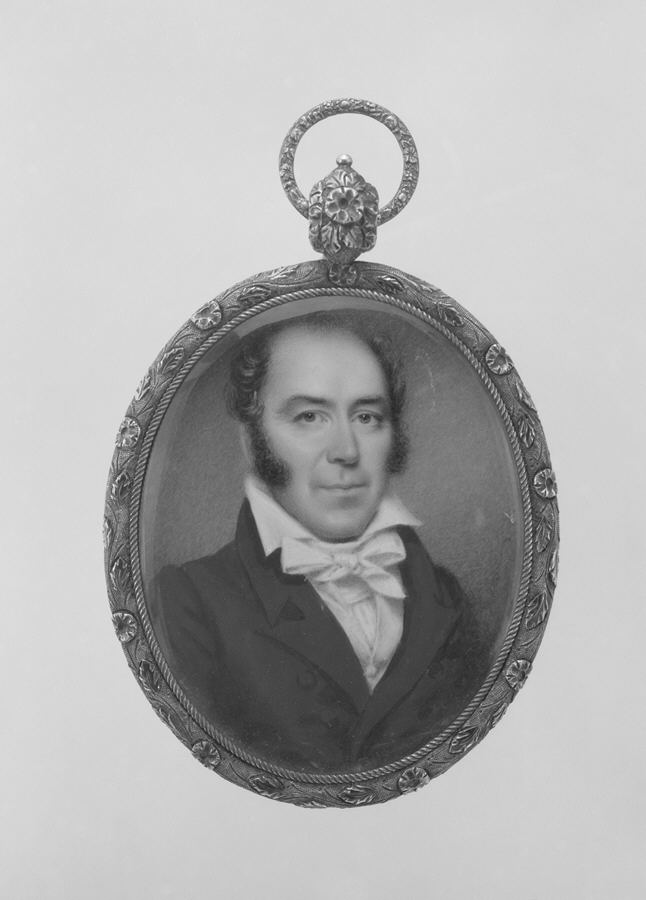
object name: painting, miniature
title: Portrait of a Gentleman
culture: american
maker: nathaniel rogers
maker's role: artist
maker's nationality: american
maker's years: 1788-1844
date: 1835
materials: ivory, watercolor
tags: men,portraits